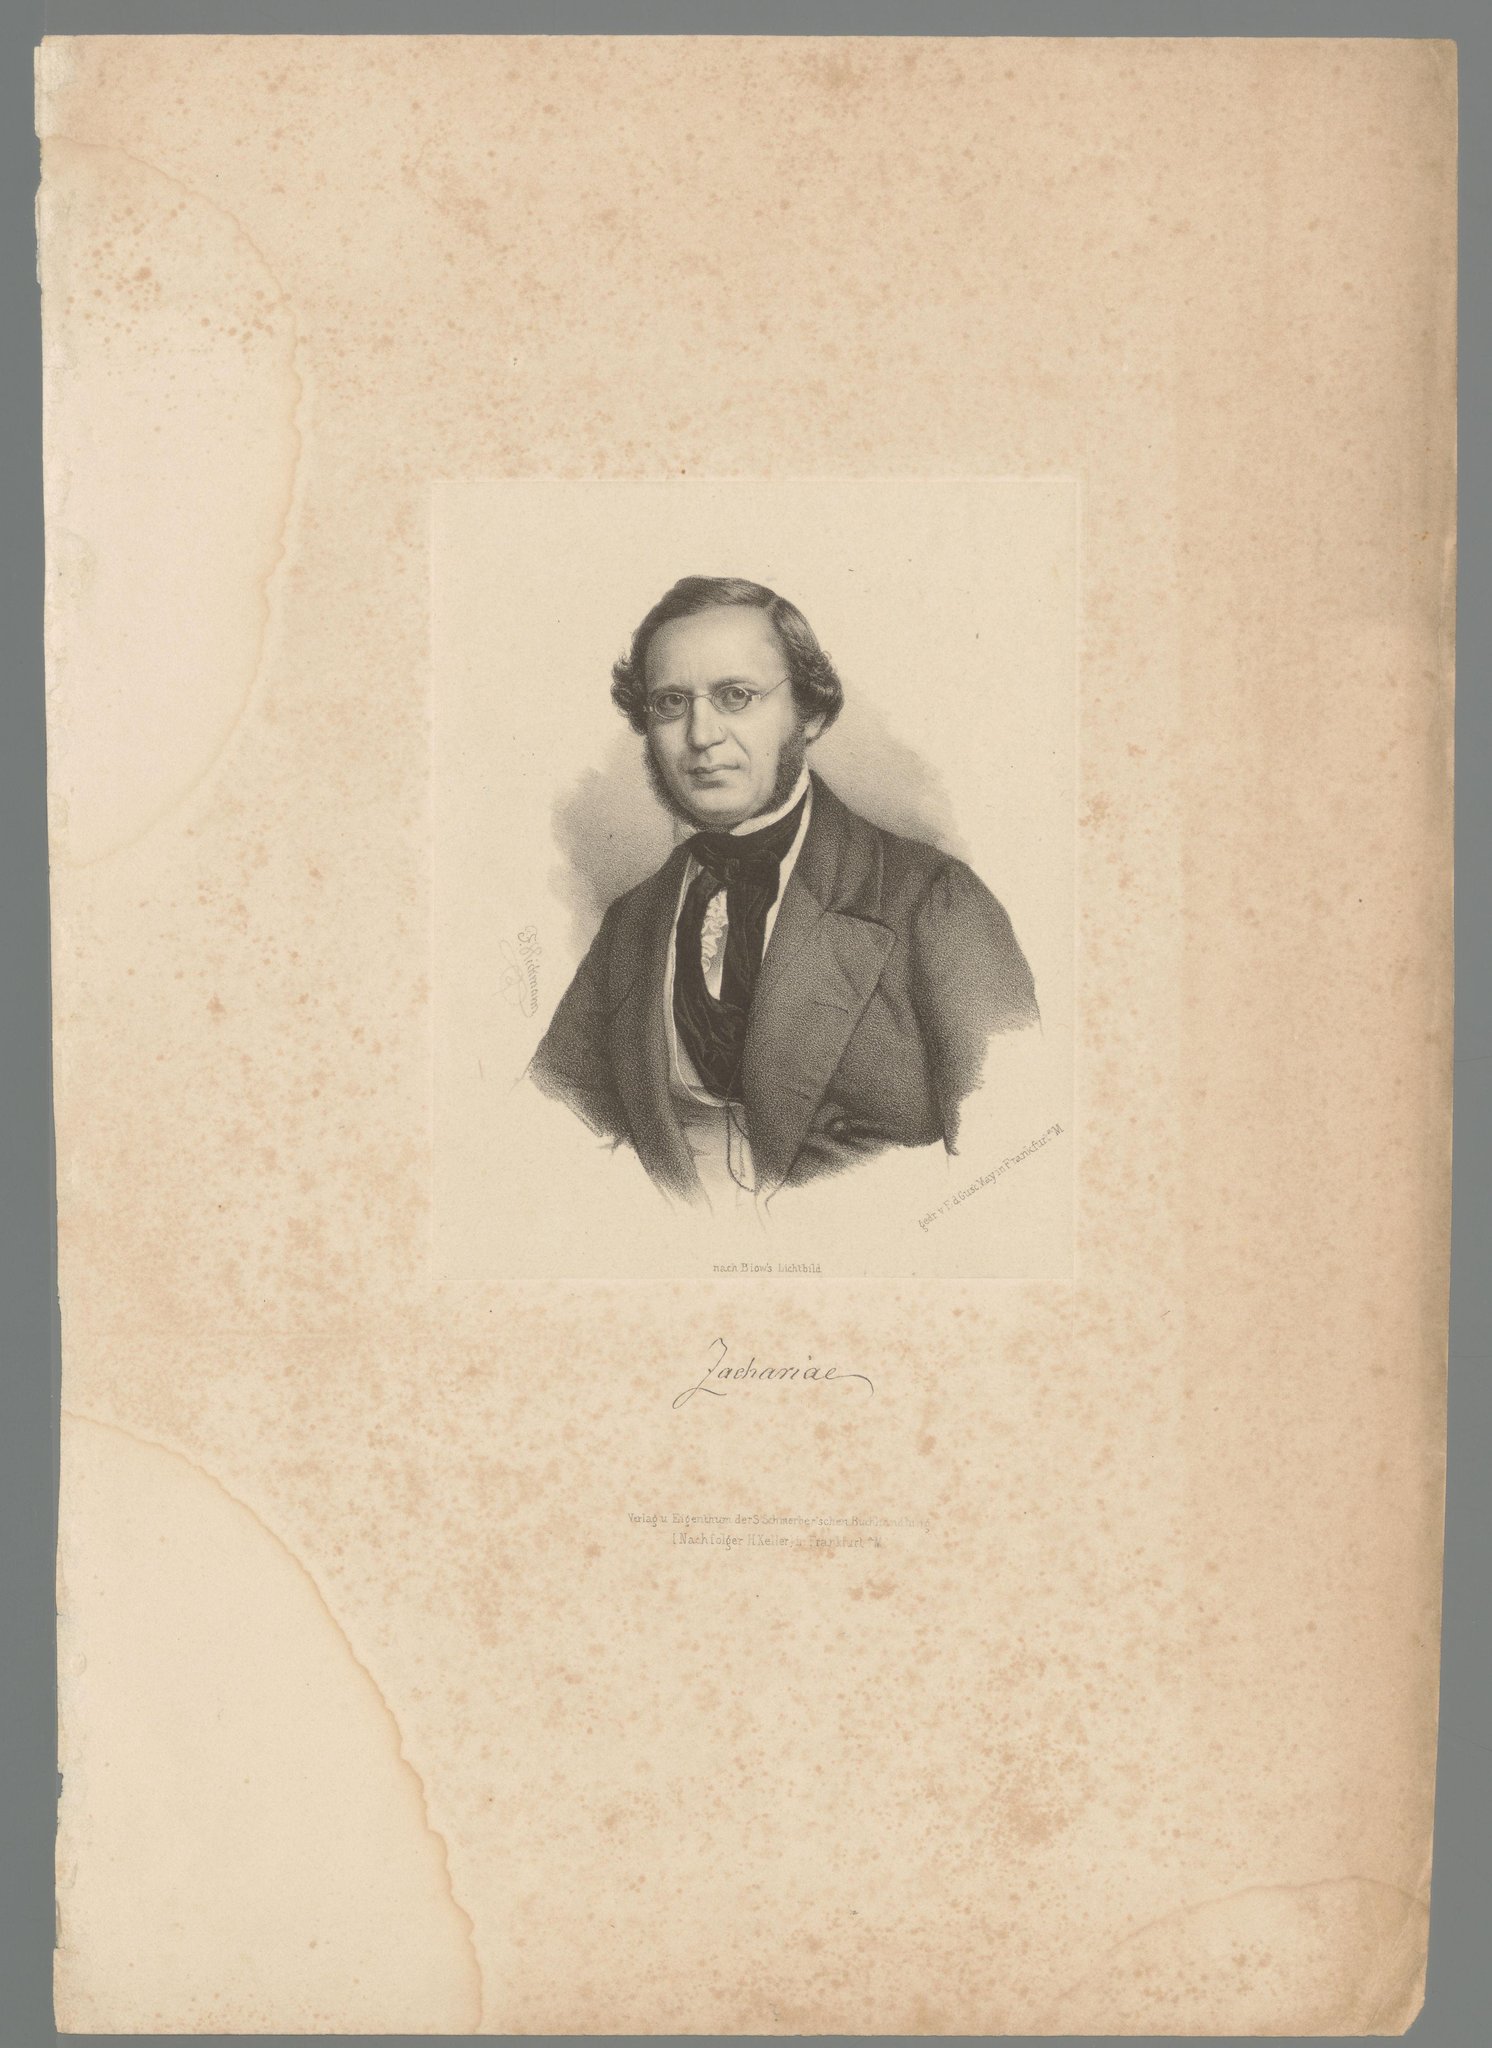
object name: print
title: Portret van Heinrich Albert Zachariä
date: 1830-1900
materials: paper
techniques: lithograph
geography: frankfurt am main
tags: politician, historical persons, politician, e.g. party leader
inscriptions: collector's mark: Lugt 2228